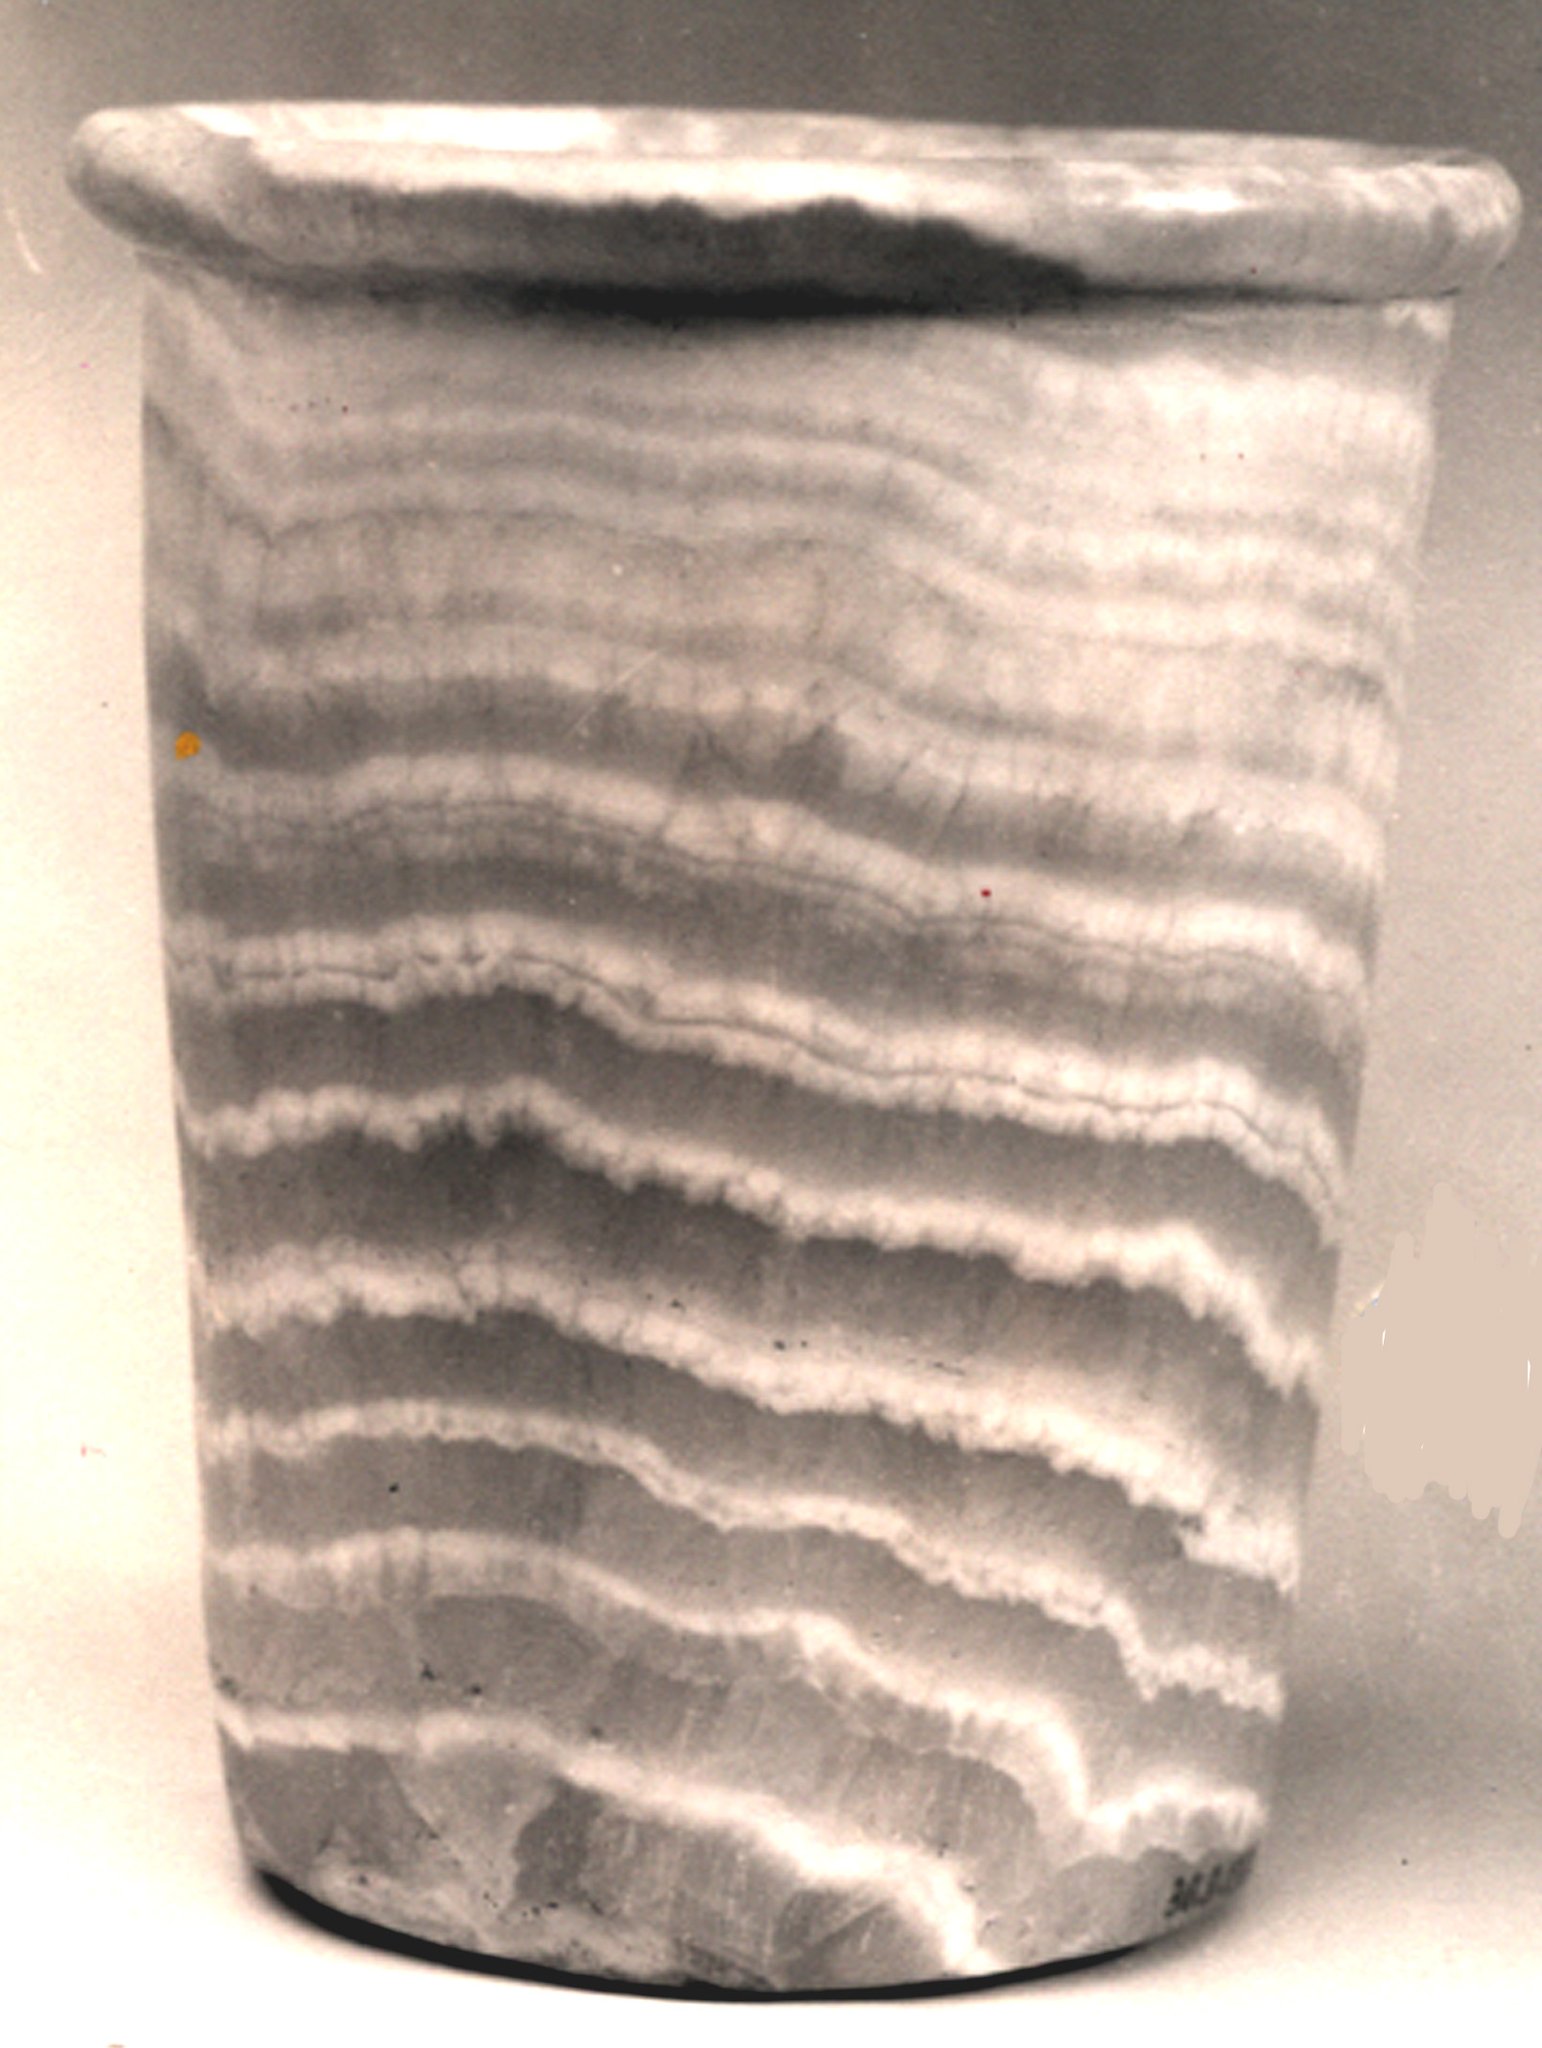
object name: vase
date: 1550-1295 BCE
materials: alabaster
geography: egypt